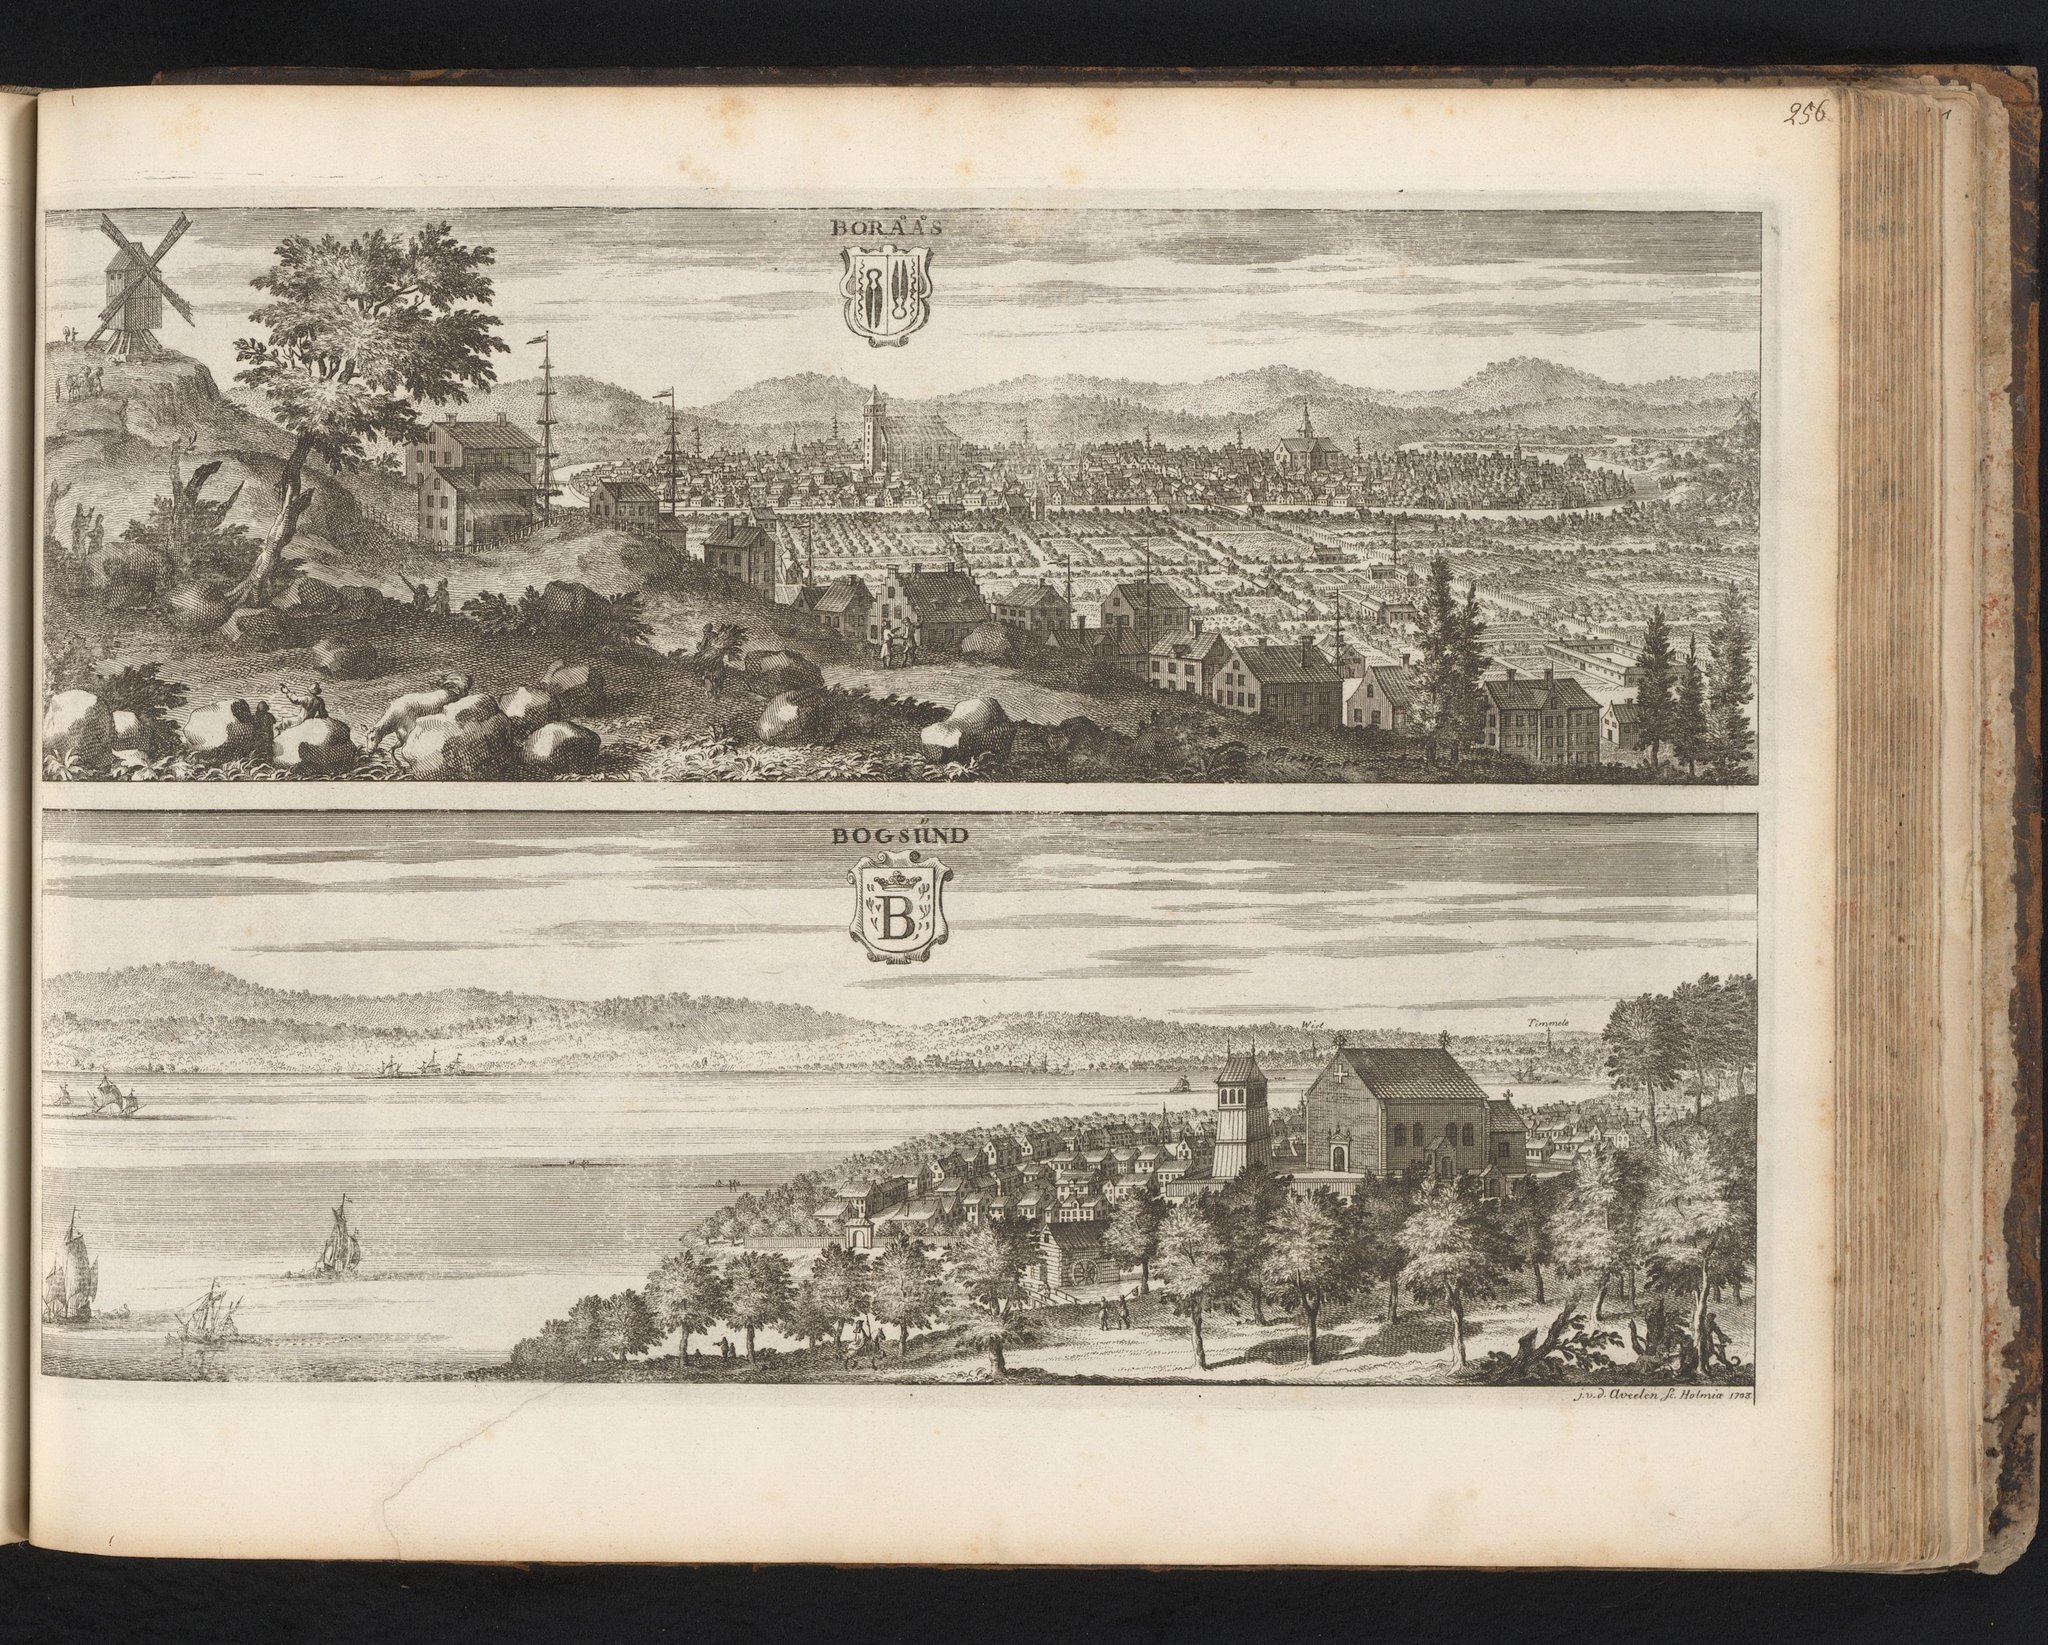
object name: album leaf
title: Suecia Antiqua et Hodierna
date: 1703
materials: paper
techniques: etching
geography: stockholm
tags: city-view in general; 'veduta'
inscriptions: date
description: Kungliga Biblioteket, 'Suecia': http://www.kb.se/samlingarna/Kartor-bilder/Suecia-antiqua/ (geraadpleegd november 2016).